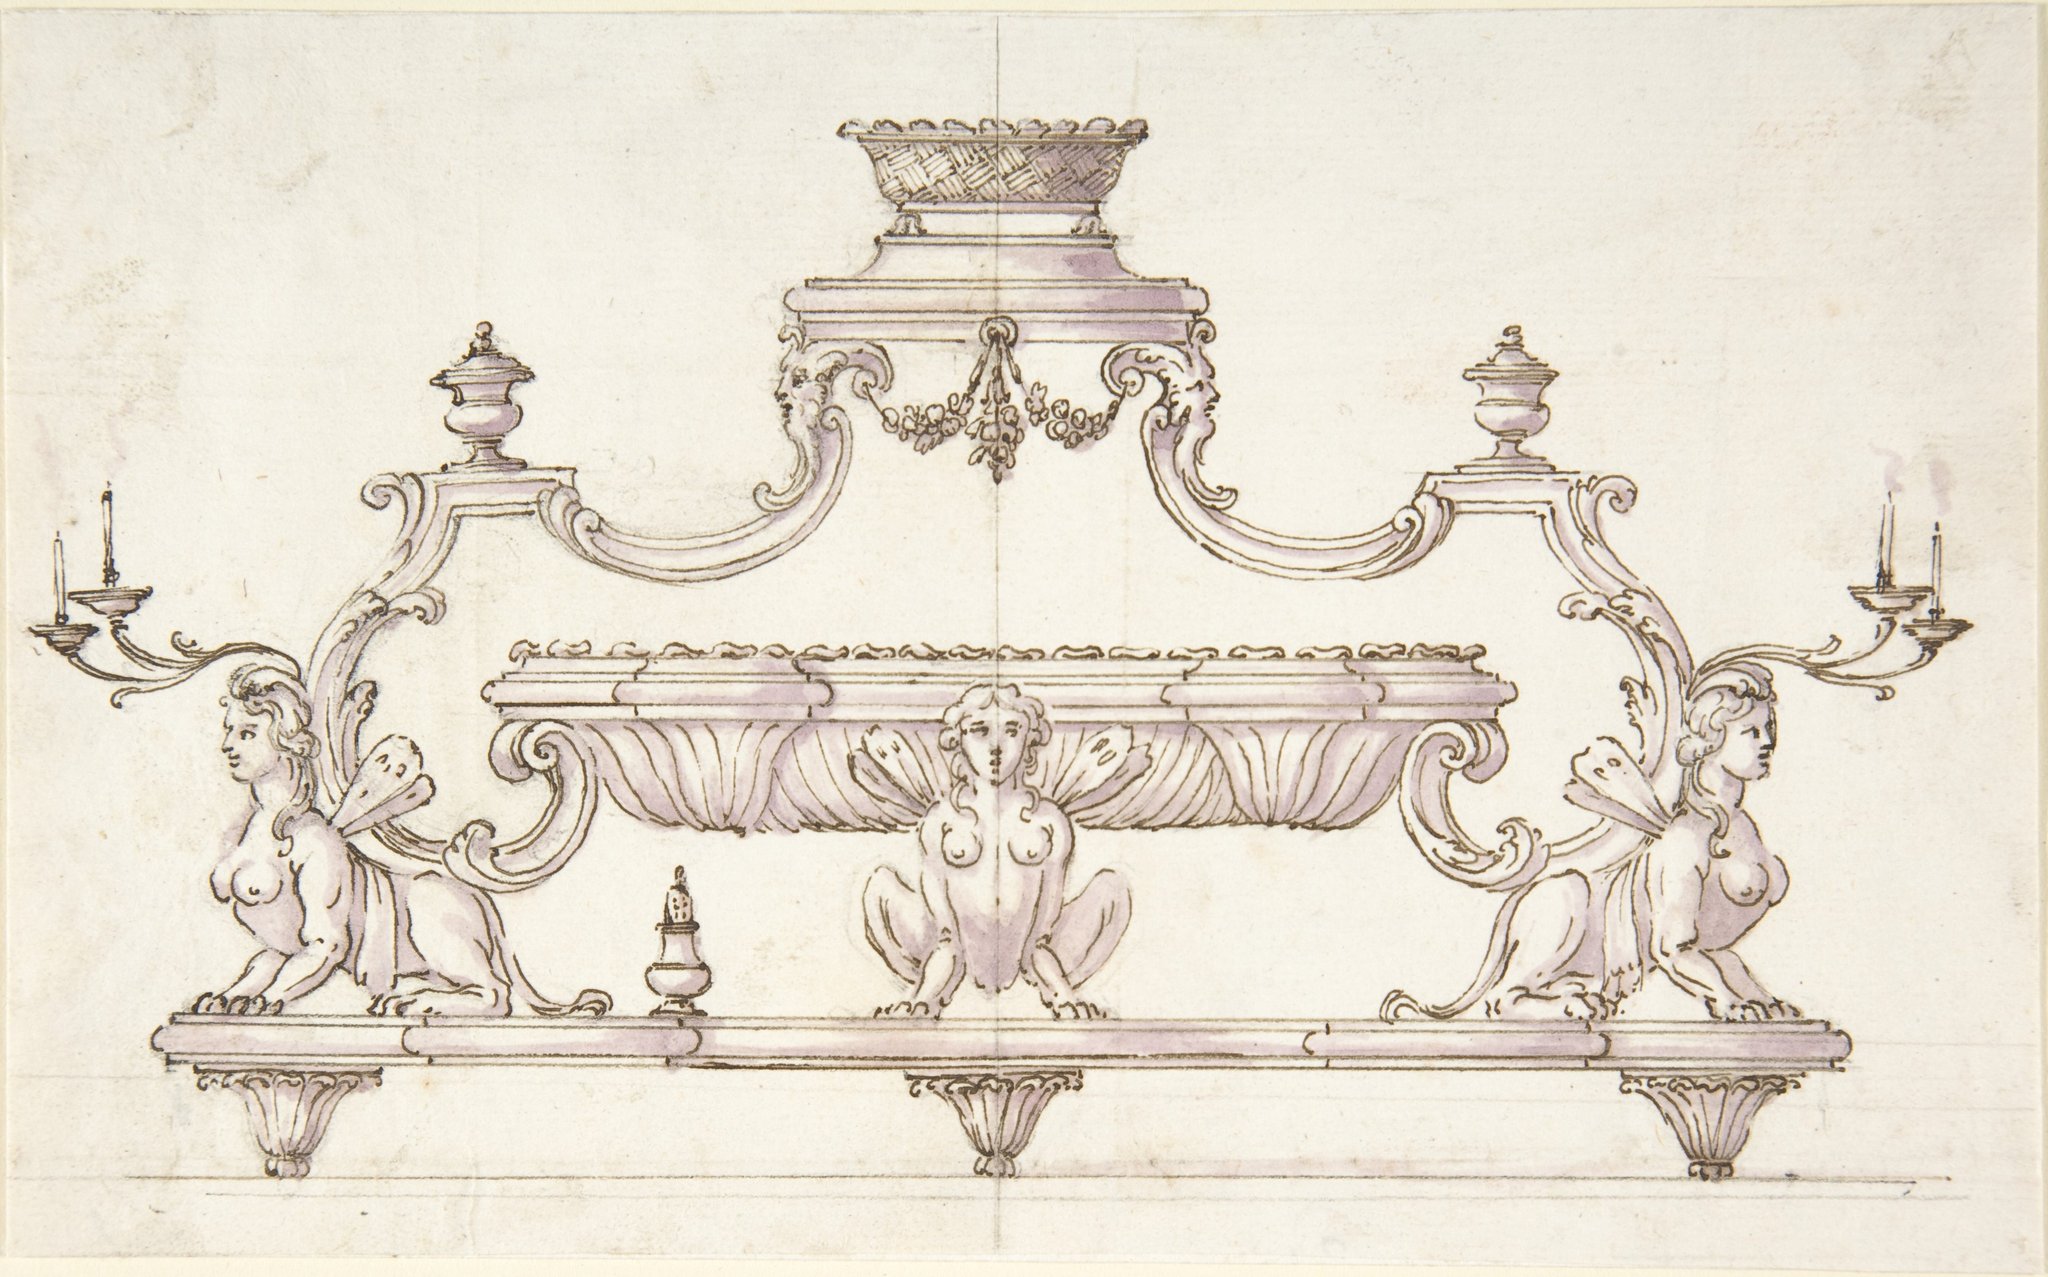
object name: drawing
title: Design for a Centerpiece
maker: anonymous, 18th century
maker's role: artist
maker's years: 1700-1800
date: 1701-1800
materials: ink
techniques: pen, wash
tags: candlesticks